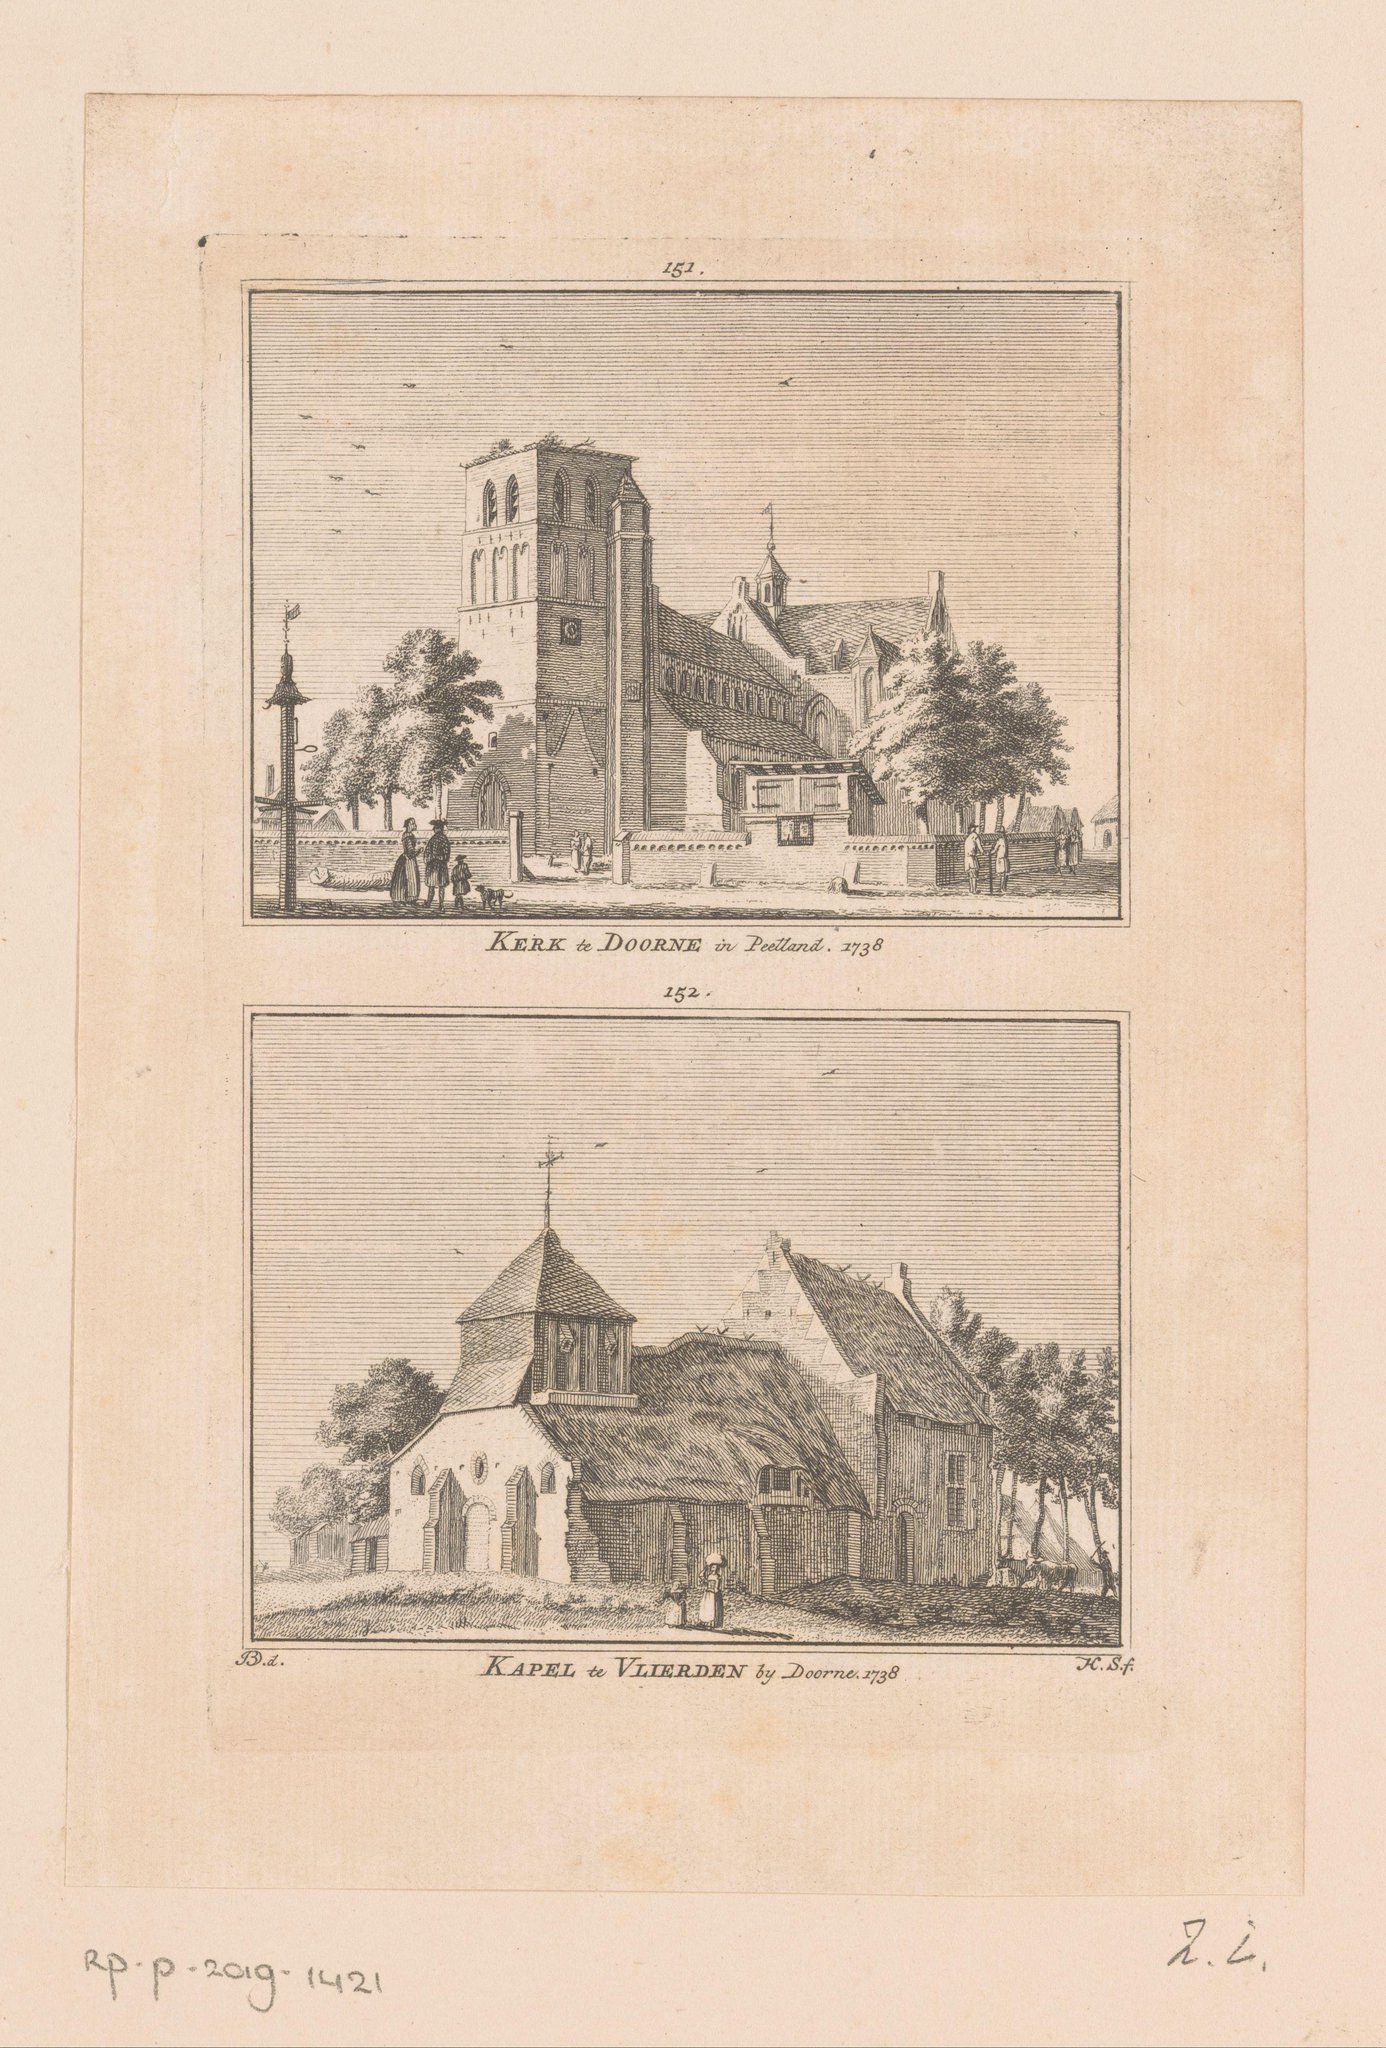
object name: print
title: Kapel te Vlierden by Doorne, 1738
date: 1746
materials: paper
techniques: engraving, etching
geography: amsterdam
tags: church (exterior), church (exterior) - qq - small church, chapel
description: Prent uit: Spilman, Hendrik. Het verheerlykt Nederland, of kabinet van hedendaagsche gezigten. 9 dln. Amsterdam: Isaac Tirion, 1745-1774, dl. 2 (1746).